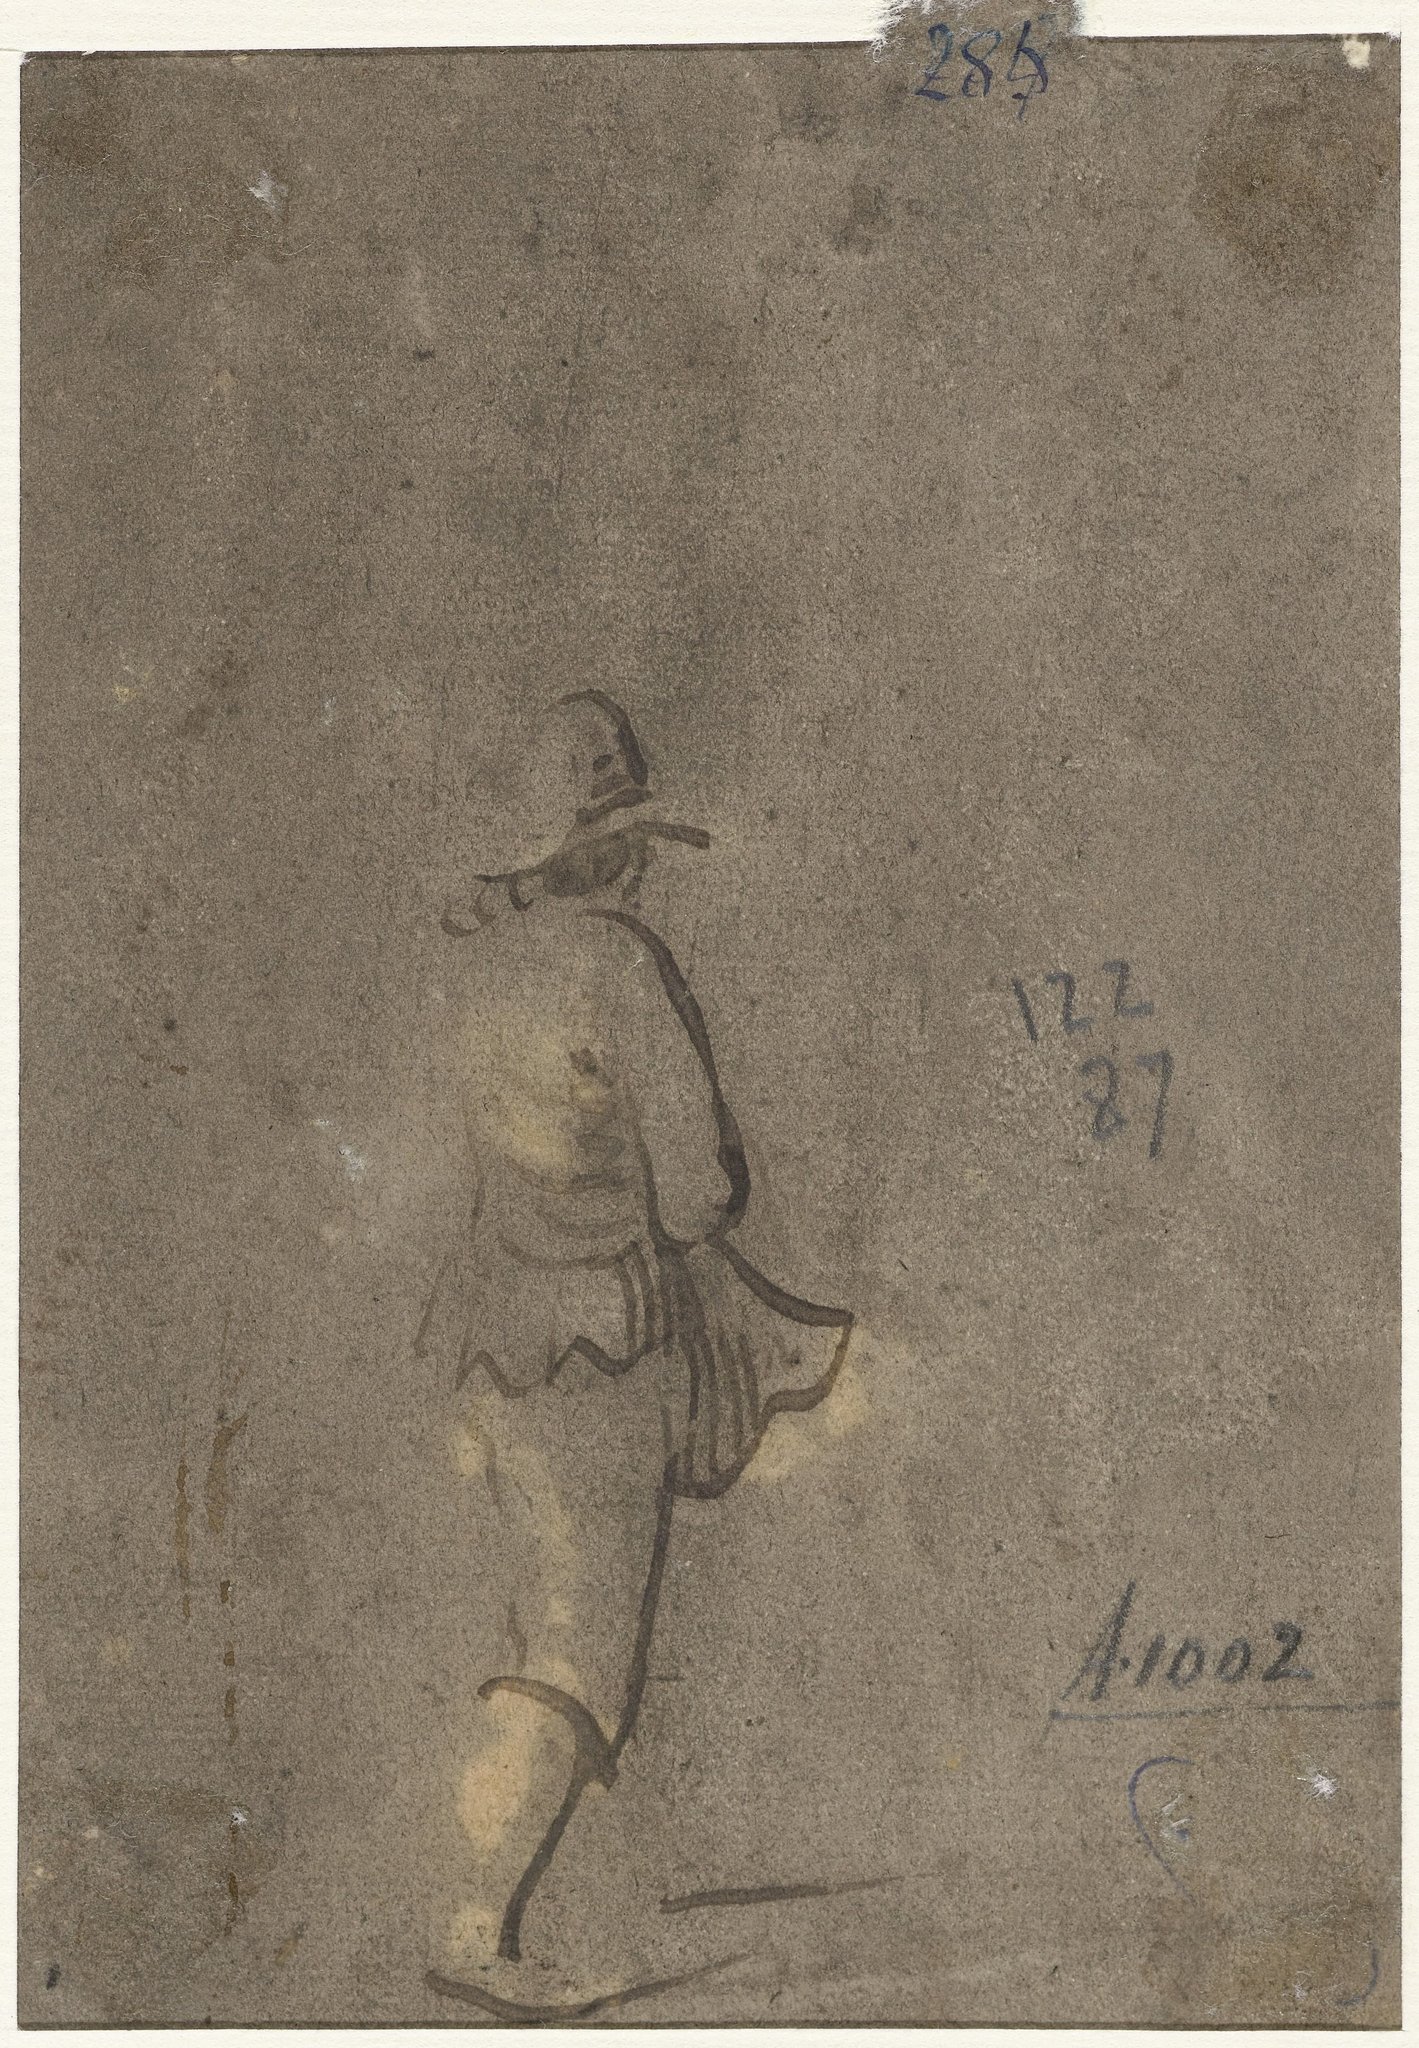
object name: drawing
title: Schets van jongen, naar rechts lopend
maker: harmen ter borch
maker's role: draughtsman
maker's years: 1638-1677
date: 1651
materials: ink, paper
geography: zwolle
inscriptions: date